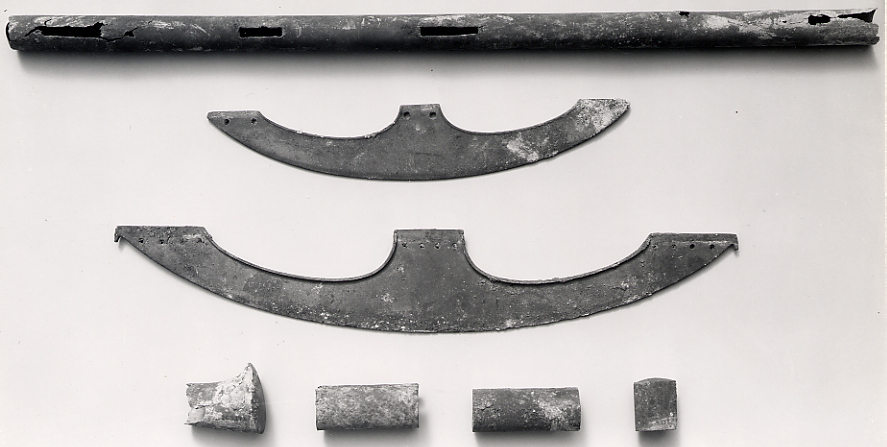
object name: ax, 5 section a blade b top ferule c d middle ferule e base ferule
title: Ax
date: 1981-1802 BCE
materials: bronze, copper alloy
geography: egypt